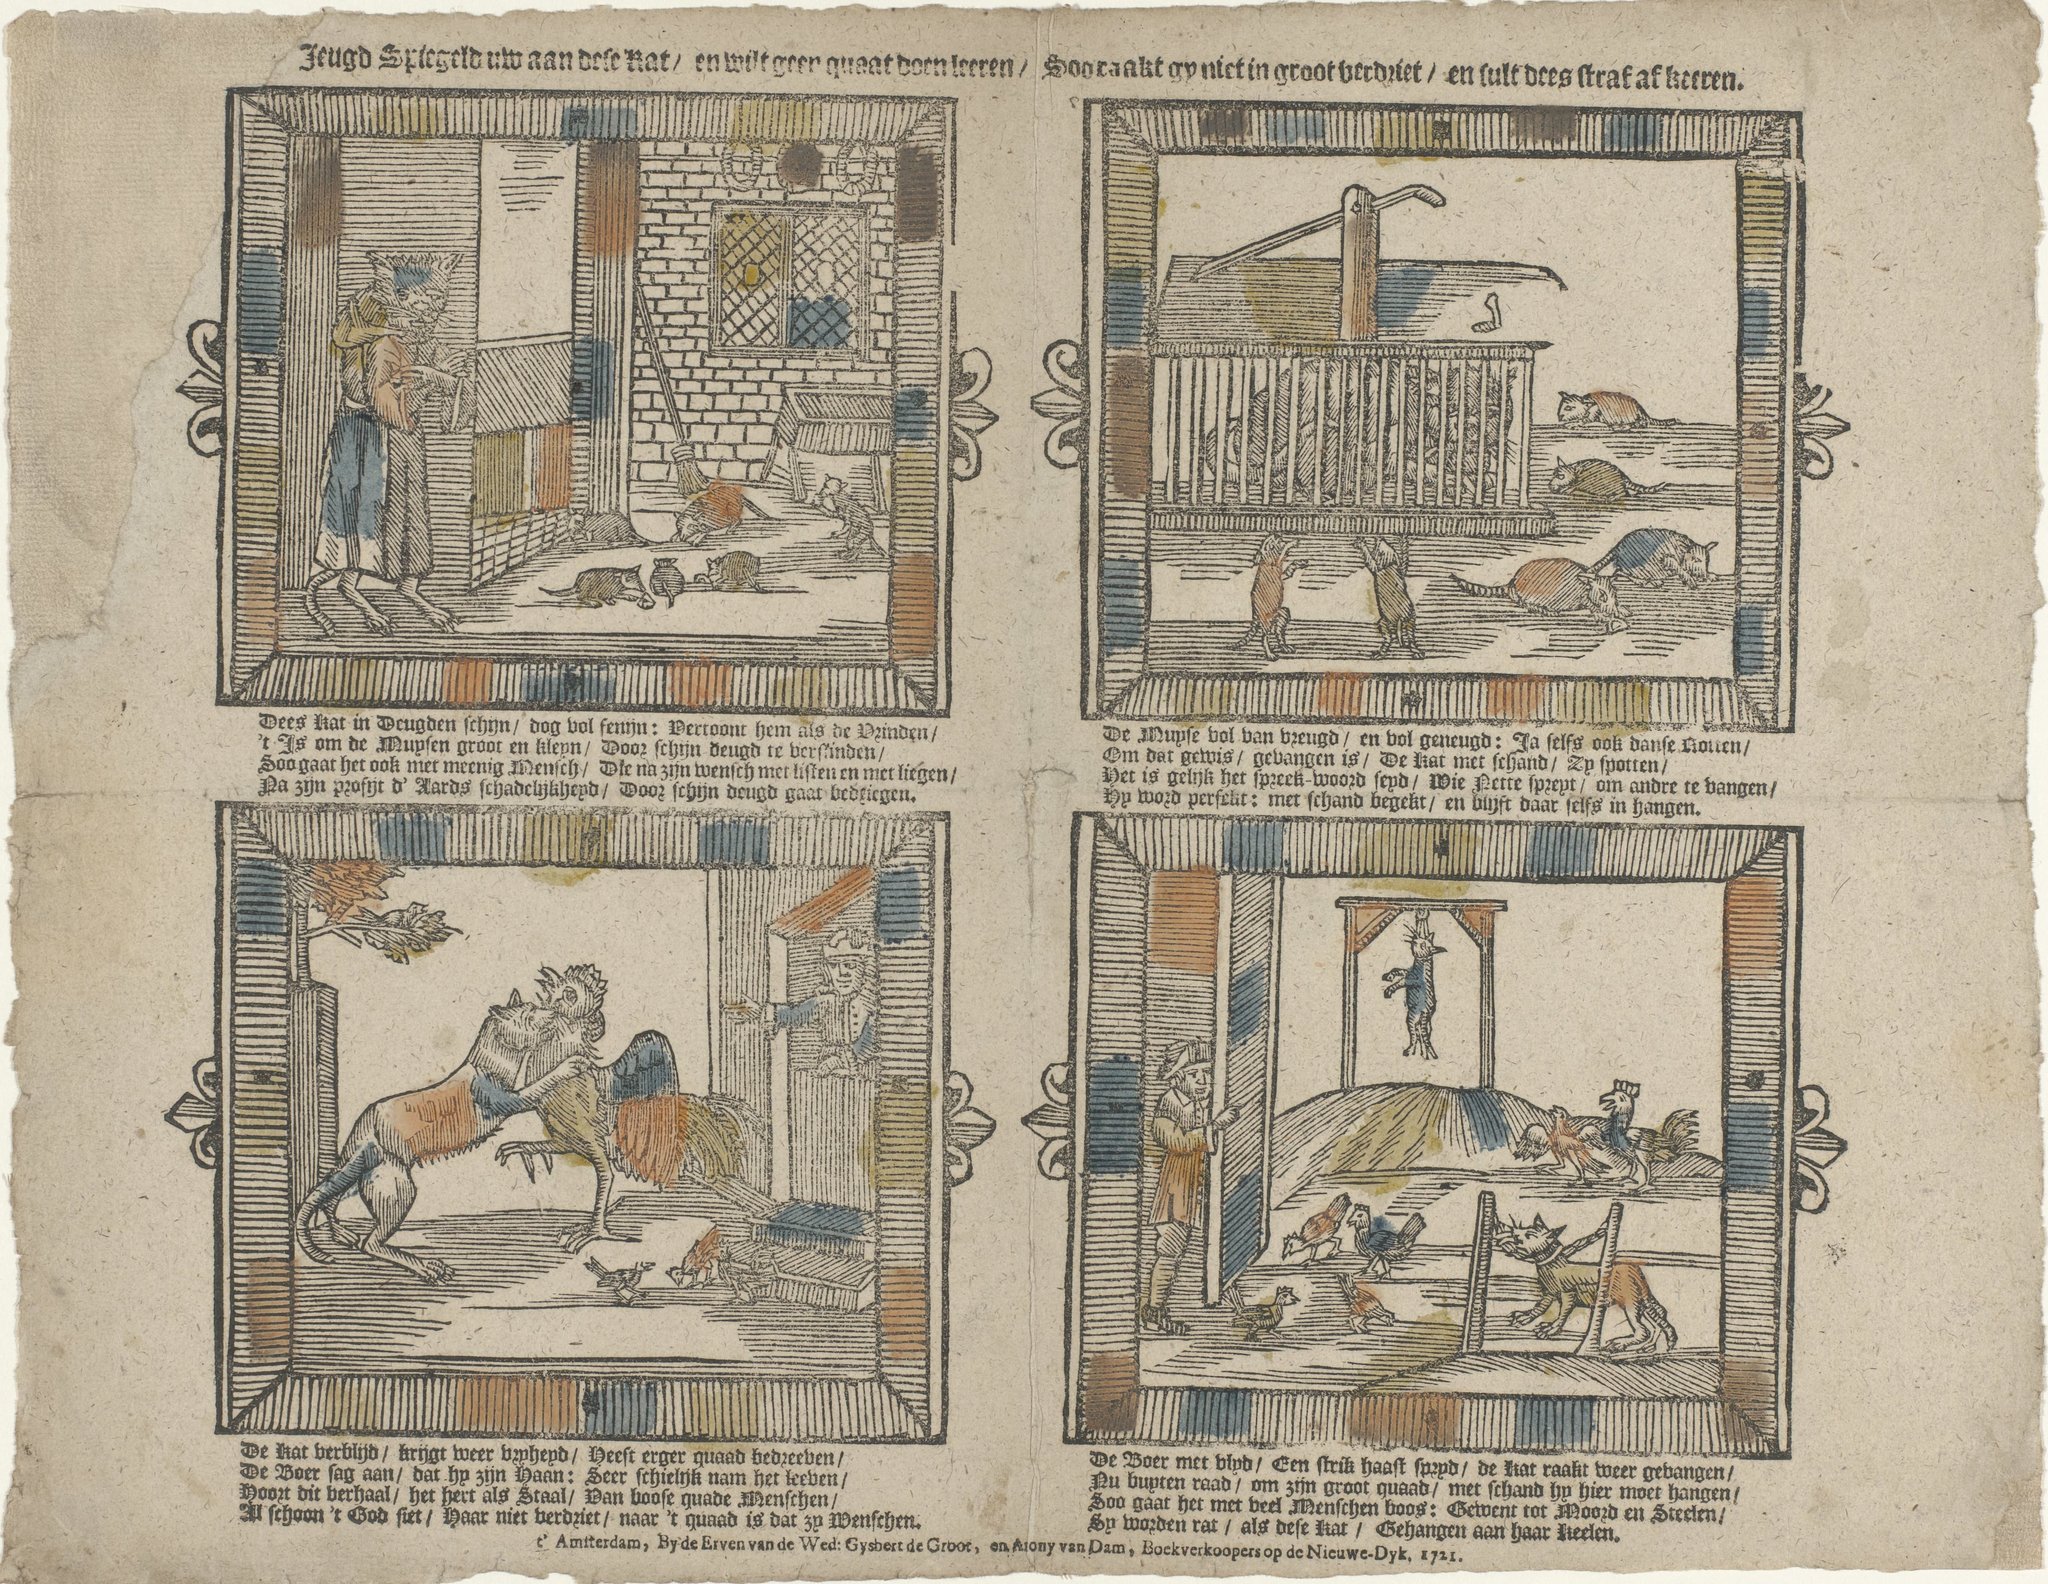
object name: print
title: Jeugd spiegeld uw aan dezen kat / en wilt geen quaat doen leeren / Soo raakt gy niet in groot verdriet / en sult dees straf af keeren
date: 1719-1724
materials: paper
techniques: colour, letterpress printing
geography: amsterdam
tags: cat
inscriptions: collector's mark: Lugt 2228, collector's mark: Lugt 2760